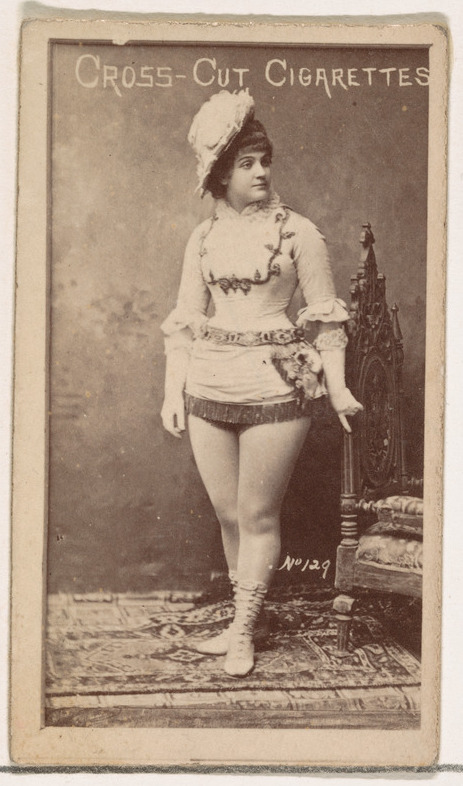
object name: print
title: Card Number 129, from the Actors and Actresses series (N145-1) issued by Duke Sons & Co. to promote Cross Cut Cigarettes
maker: w. duke, sons & co.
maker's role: publisher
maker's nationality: american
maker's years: 1870-1920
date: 1880-1889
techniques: albumen silver print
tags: portraits,women,actresses